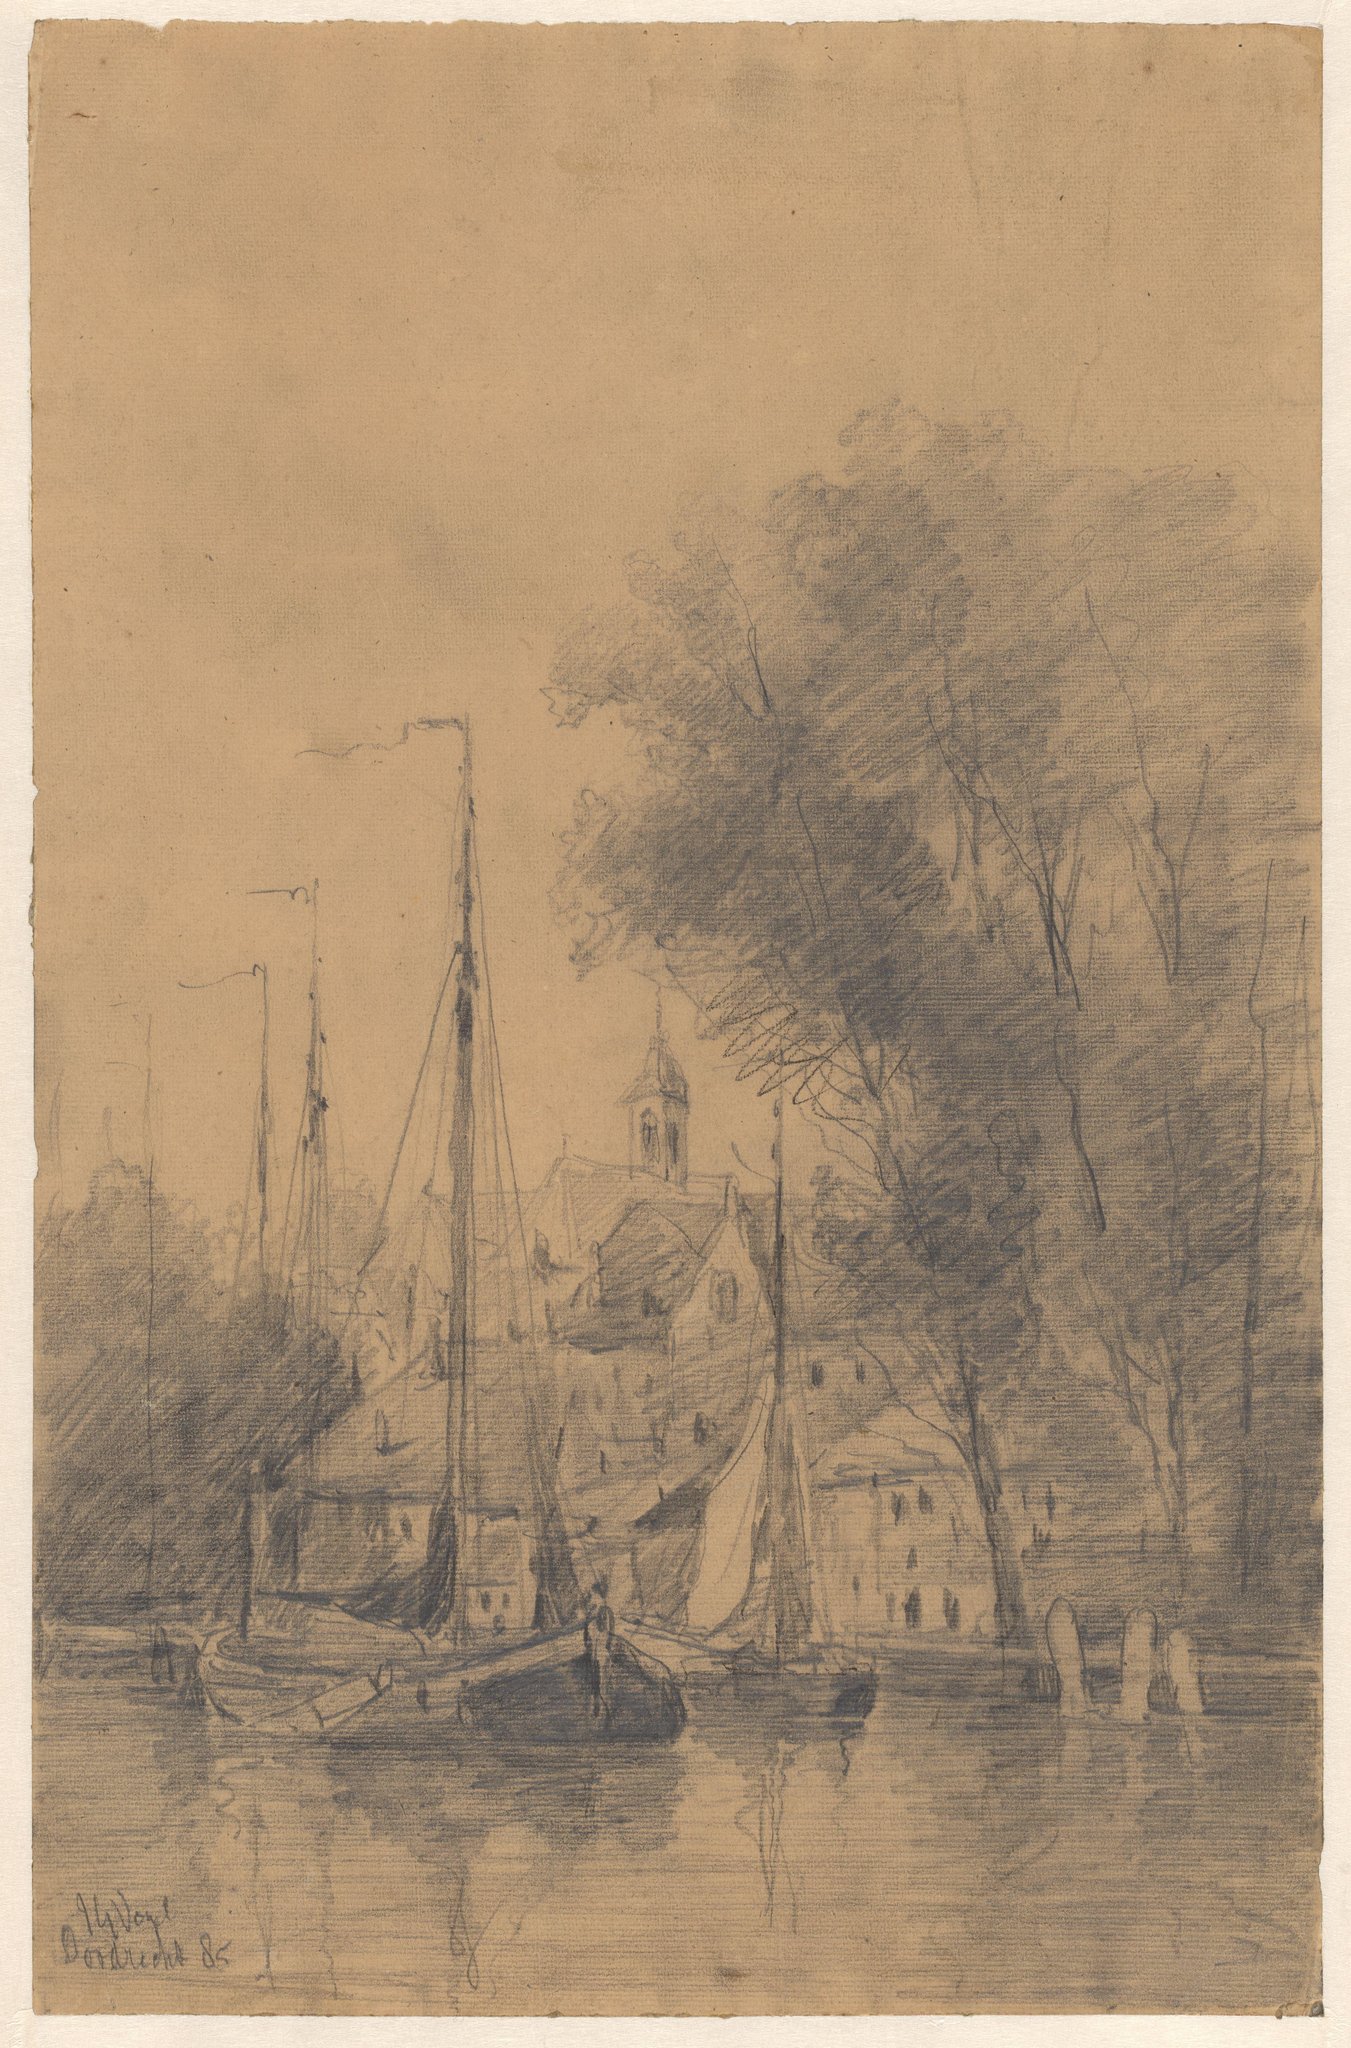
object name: drawing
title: Gezicht op Dordrecht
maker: johannes gijsbert vogel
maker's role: draughtsman, painter, print maker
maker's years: 1828-1915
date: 1885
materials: chalk, paper, pencil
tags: city-view, and landscape with man-made constructions, dordrecht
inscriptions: date and inscription: ‘Dordrecht 85’, collector's mark: Lugt 1181b